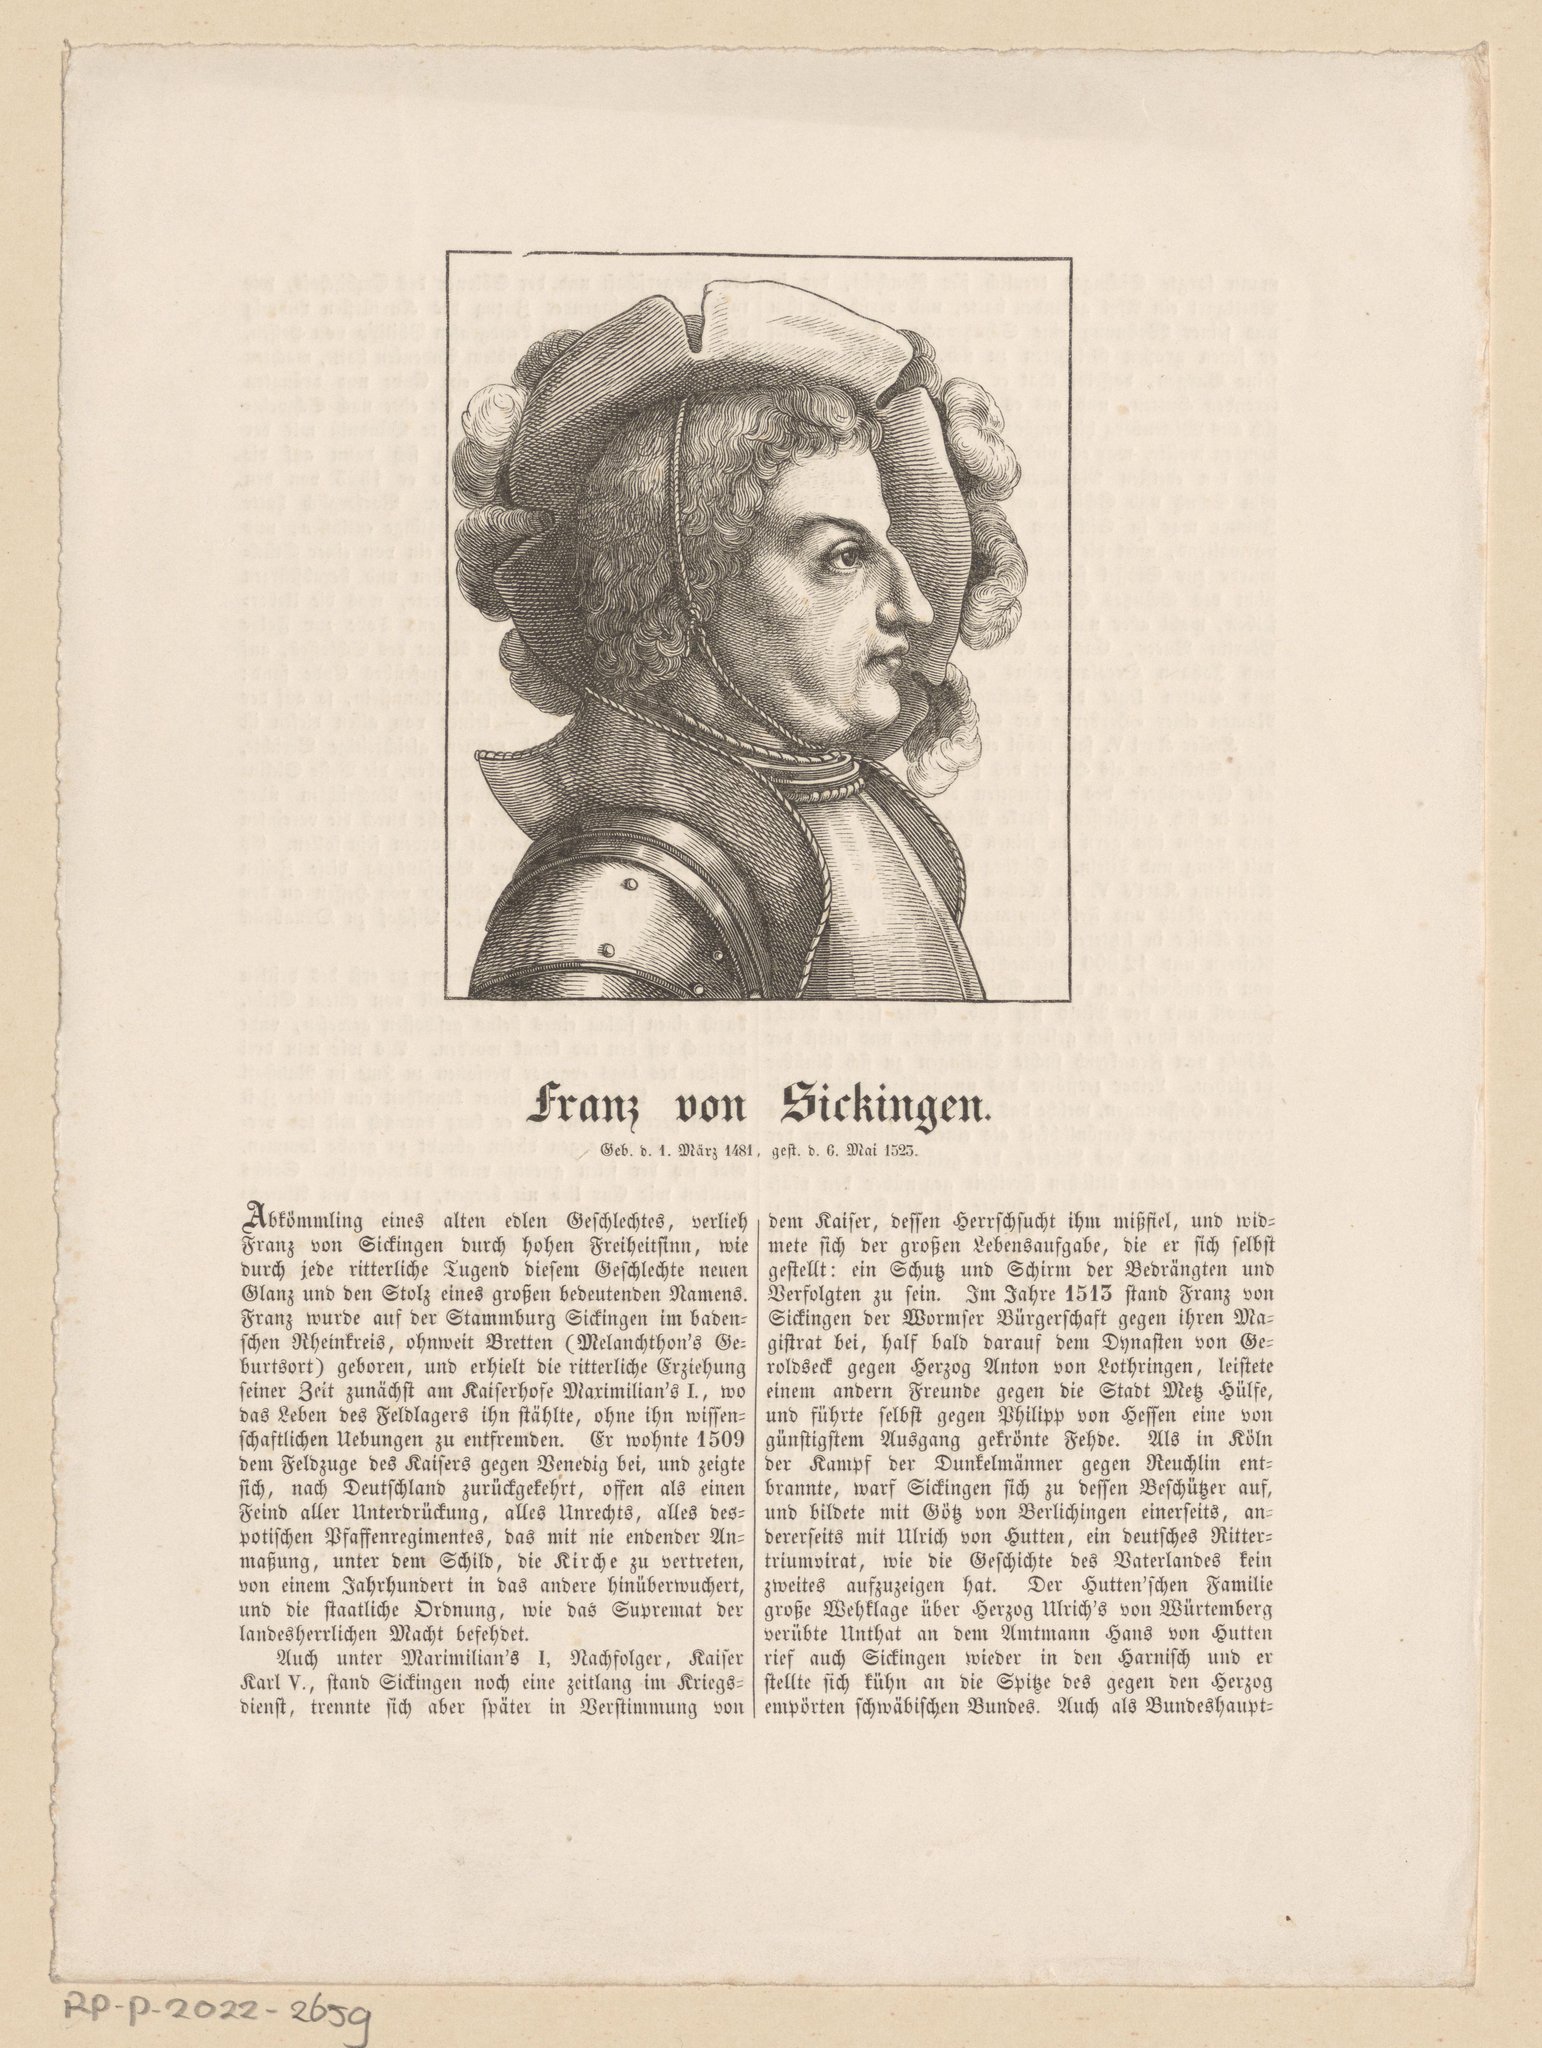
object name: book illustration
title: Portret van Franz von Sickingen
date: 1854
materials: paper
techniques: letterpress printing, engraving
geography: leipzig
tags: armour, historical persons, knight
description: Bladzijde uit: Bechstein, Ludwig. Zweihundert deutsche Männer in Bildnissen und Lebensbeschreibungen. Leipzig: Georg Wigand, 1854. Prent met andere tekst gebruikt in: Gaedertz, Karl Theodor. Dreihundert Bildnisse und Lebensabrisse berühmter deutscher Männer. Leipzig: Georg Wigand, 1890. Bij de uitgave uit 1890 staat op de titelpagina vermeld dat de prenten zijn gemaakt door Hugo Bürkner.